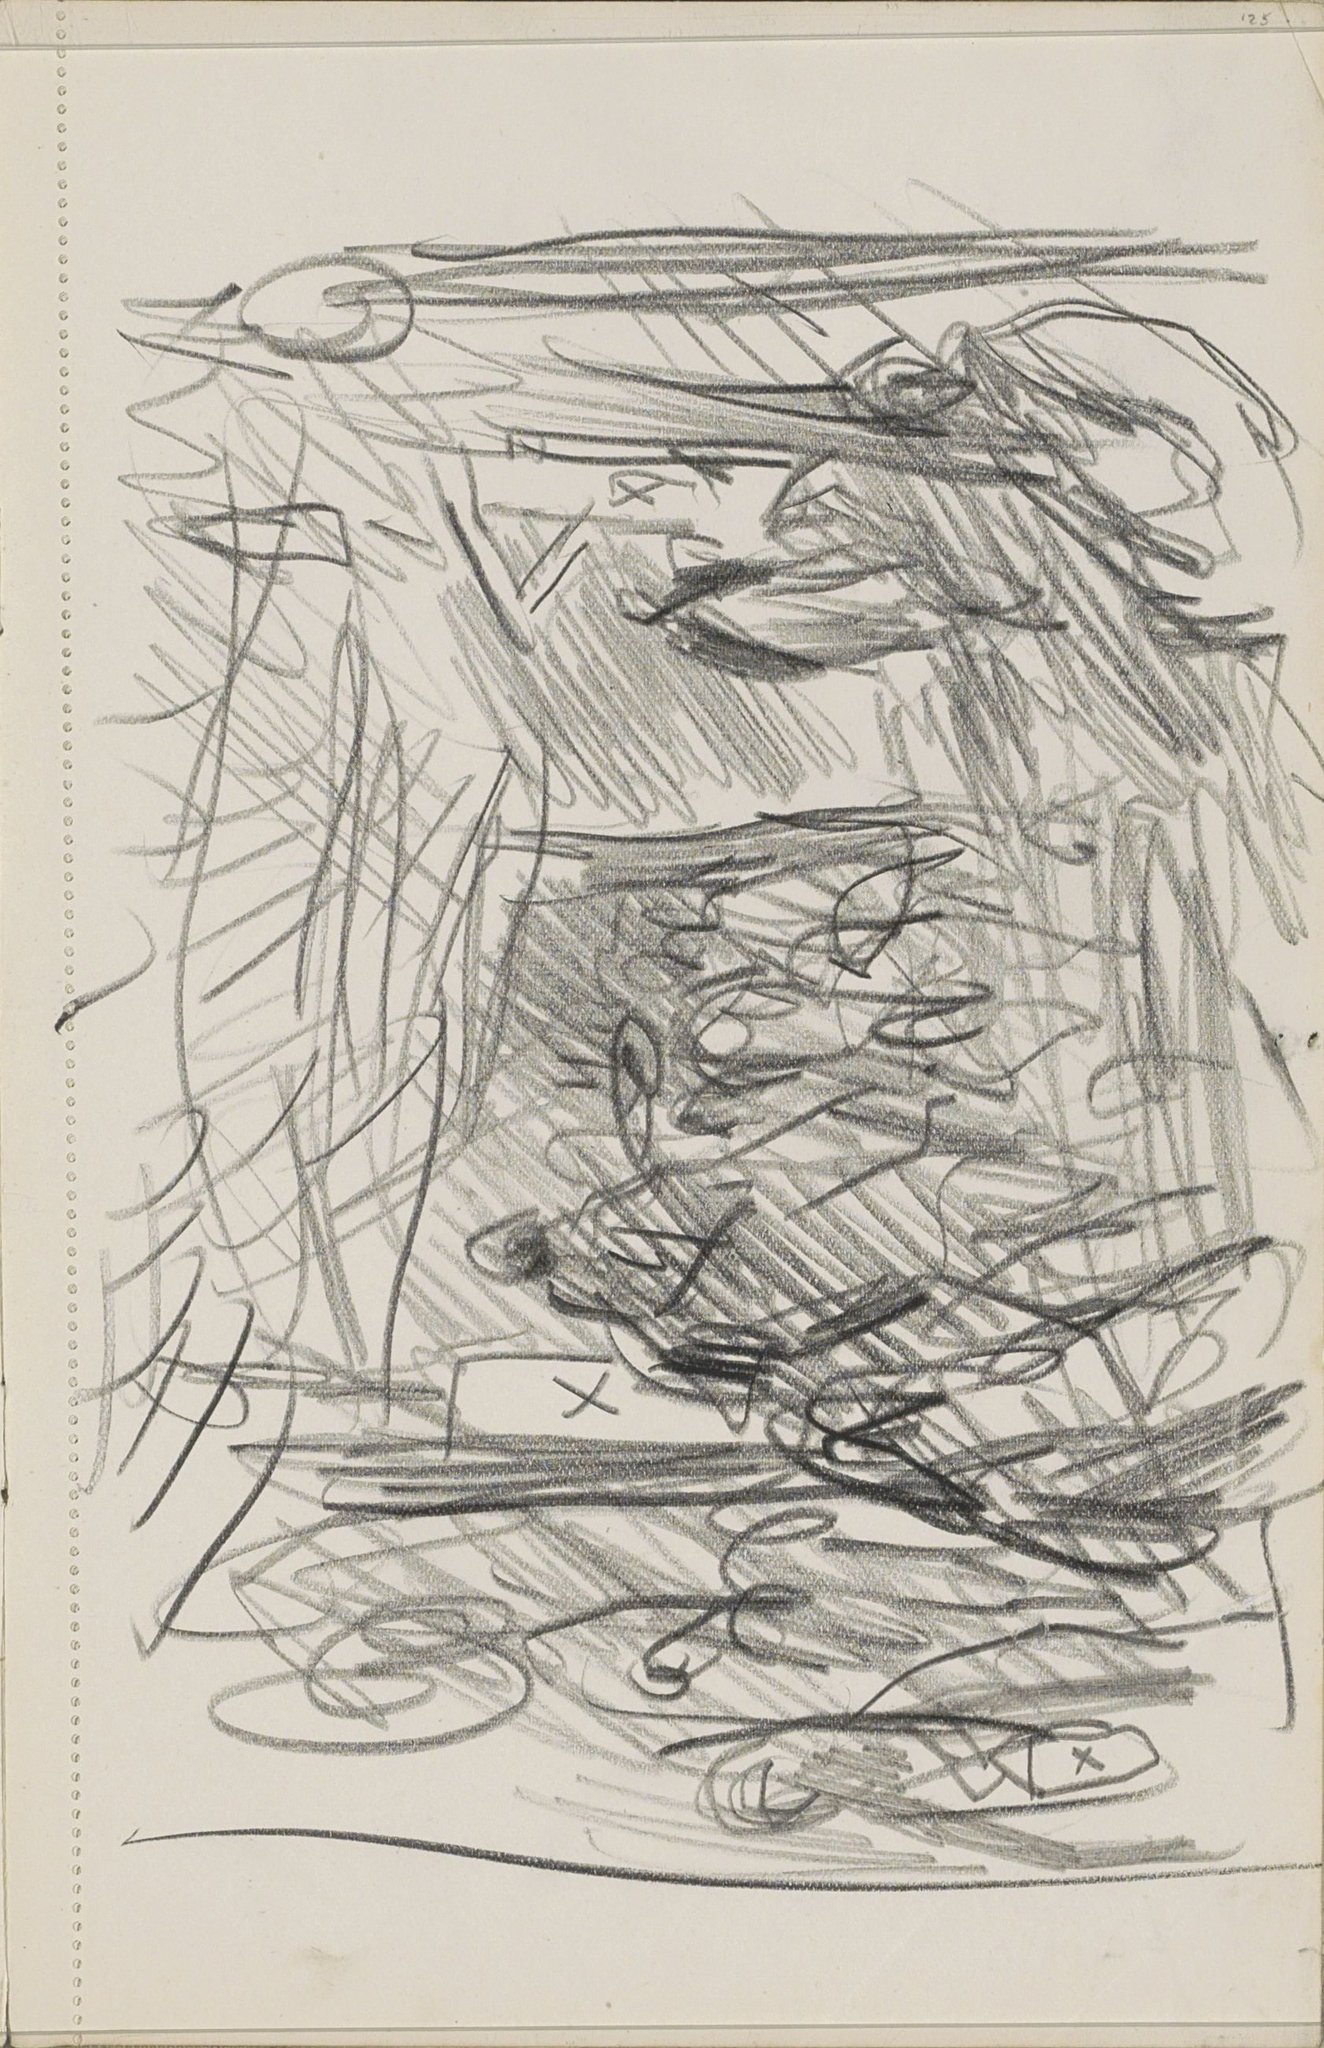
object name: sketchbook leaf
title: Overdekte straat met figuren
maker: marius bauer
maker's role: draughtsman, print maker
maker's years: 1867-1932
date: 1923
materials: paper, pencil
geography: morocco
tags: street (+ city(-scape) with figures, staffage)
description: Pagina 125 uit een schetsboek met 66 bladen.